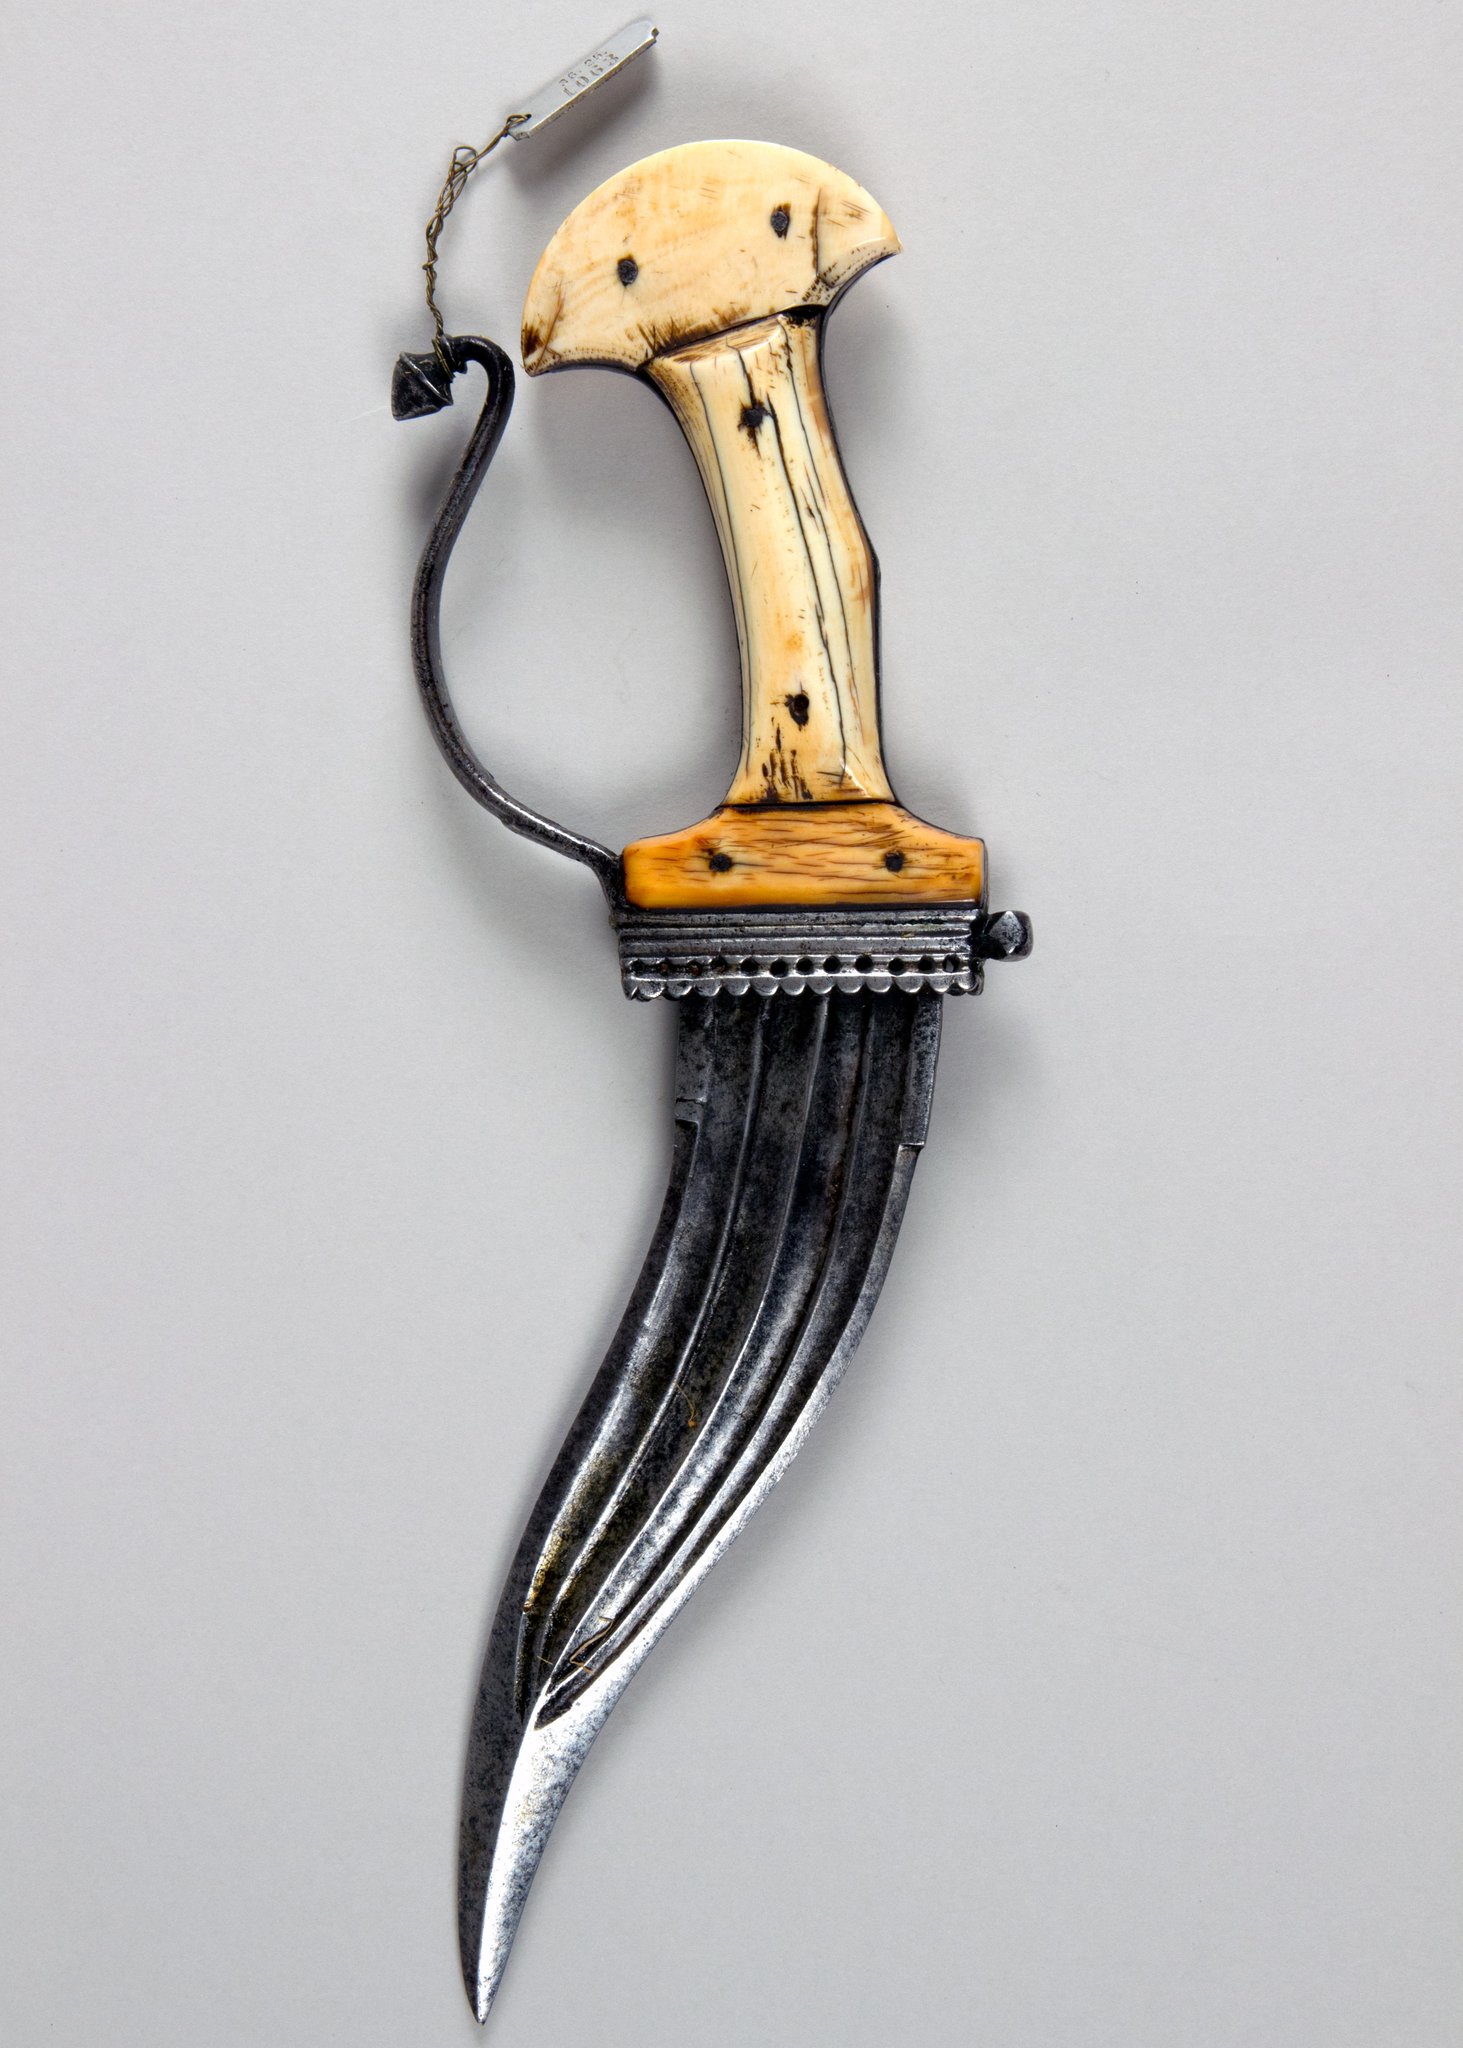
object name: dagger khanjar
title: Dagger (Khanjarli)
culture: indian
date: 1601-1800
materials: ivory, steel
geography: india